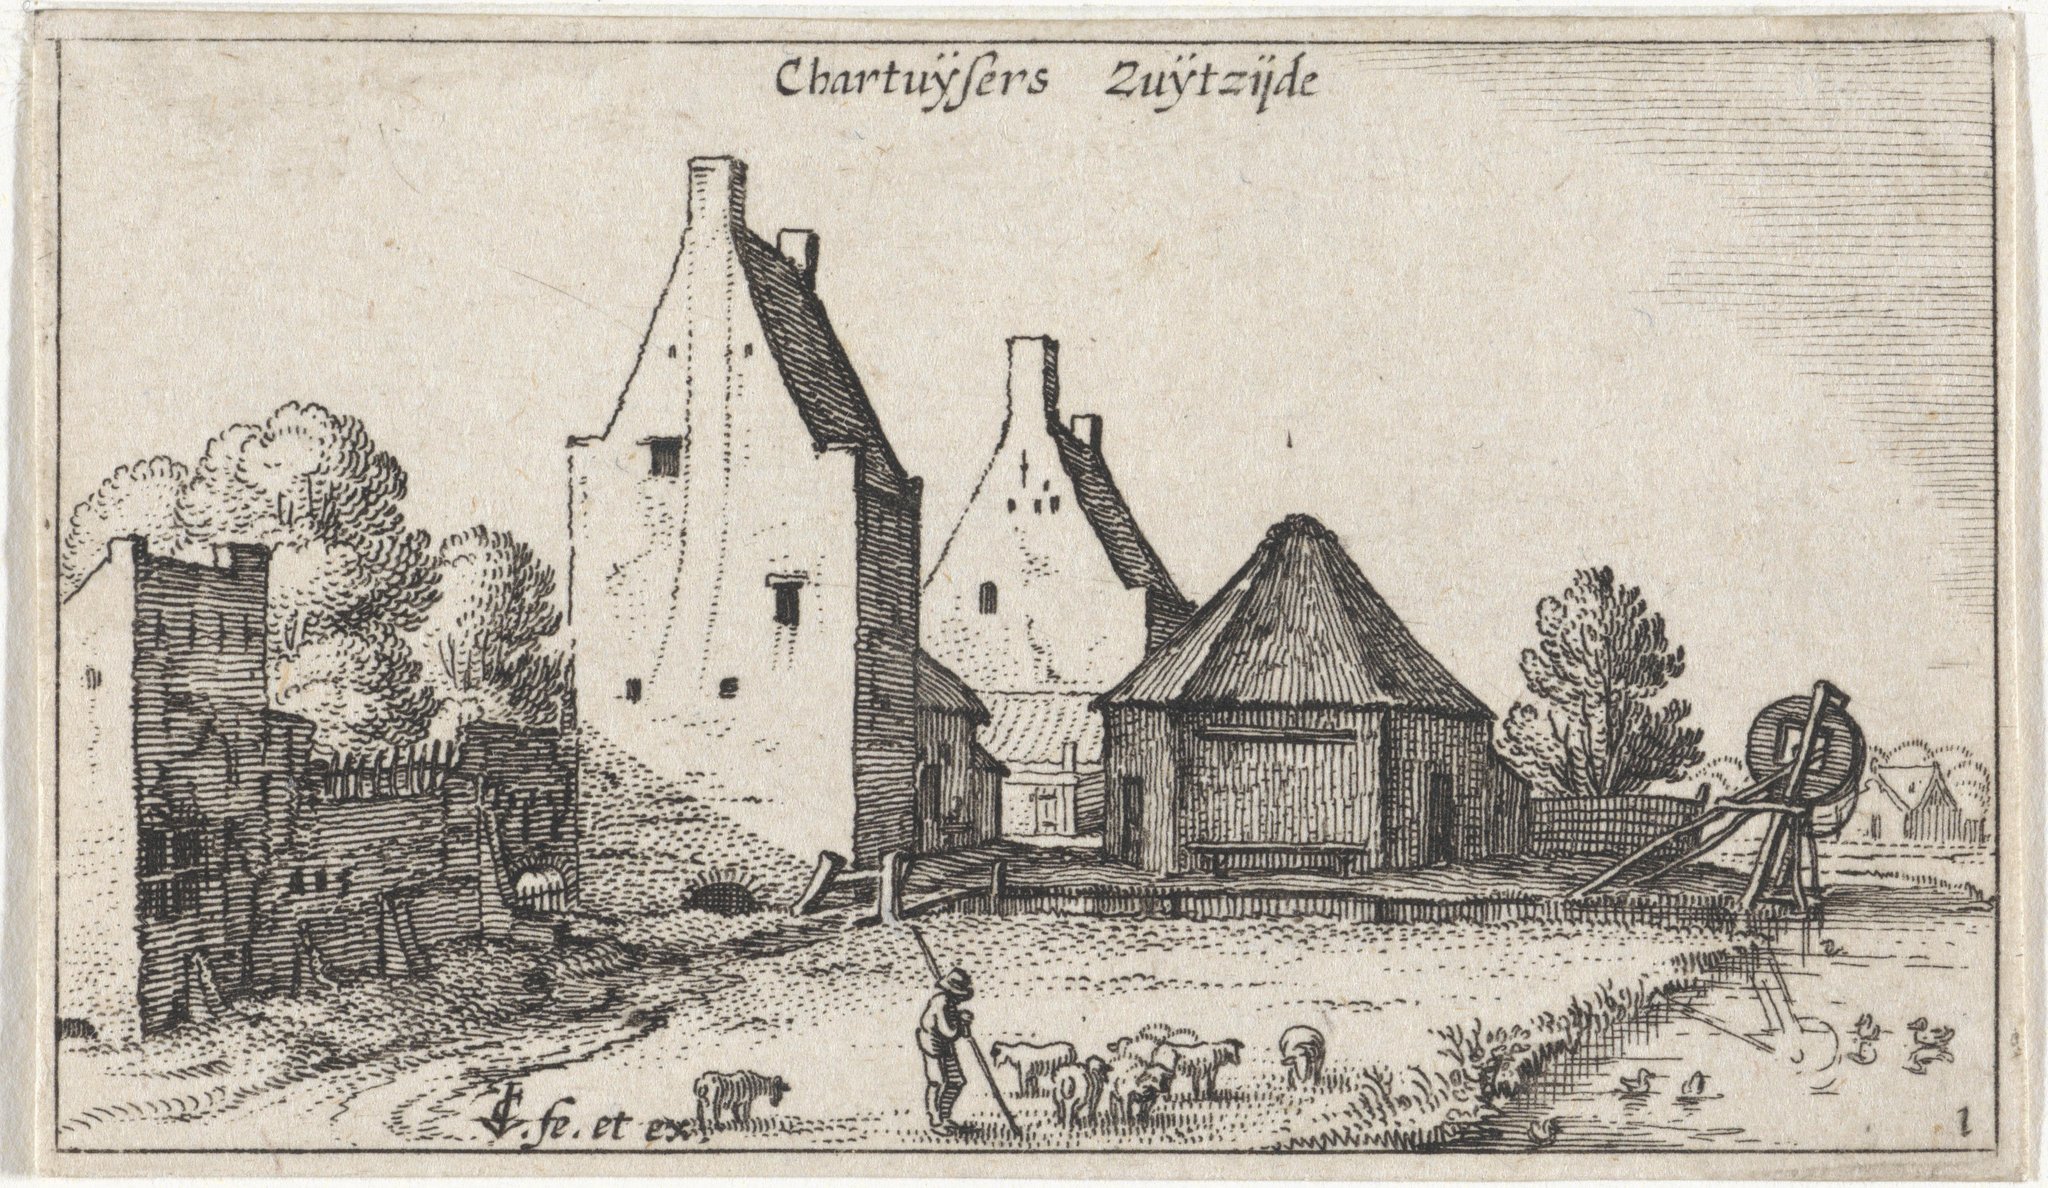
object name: print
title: Kleine landschappen in de omgeving van Amsterdam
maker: claes jansz. visscher (ii)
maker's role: draughtsman, print maker, publisher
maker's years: 1586-1652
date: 1612-1652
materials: paper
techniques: etching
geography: amsterdam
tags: herding, herdsman, herdswoman, shepherd, shepherdess, cowherd, etc., cloisters ~ monastery, watermill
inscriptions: signature and address: ‘CIV fe et exc.’ Lugt, title: ‘Chartuysers Zuytzijde’, collector's mark: 2228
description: Gezicht op de zuidzijde van het Kartuizerklooster nabij Amsterdam. Op de voorgrond een herder met schapen. Deze prent maakt deel uit van een serie met kleine landschappen in de omgeving van Amsterdam.